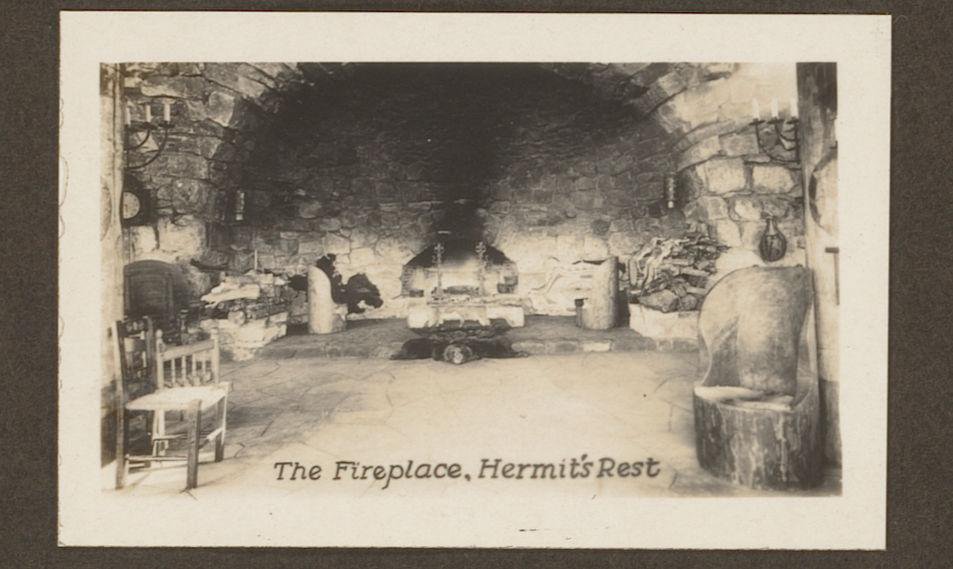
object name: photograph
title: The fireplace, Hermit's Rest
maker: Anonymous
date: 1928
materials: photographic support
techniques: gelatin silver print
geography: grand canyon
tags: open hearth, fire-place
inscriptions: annotation: ‘Grand Canyon’